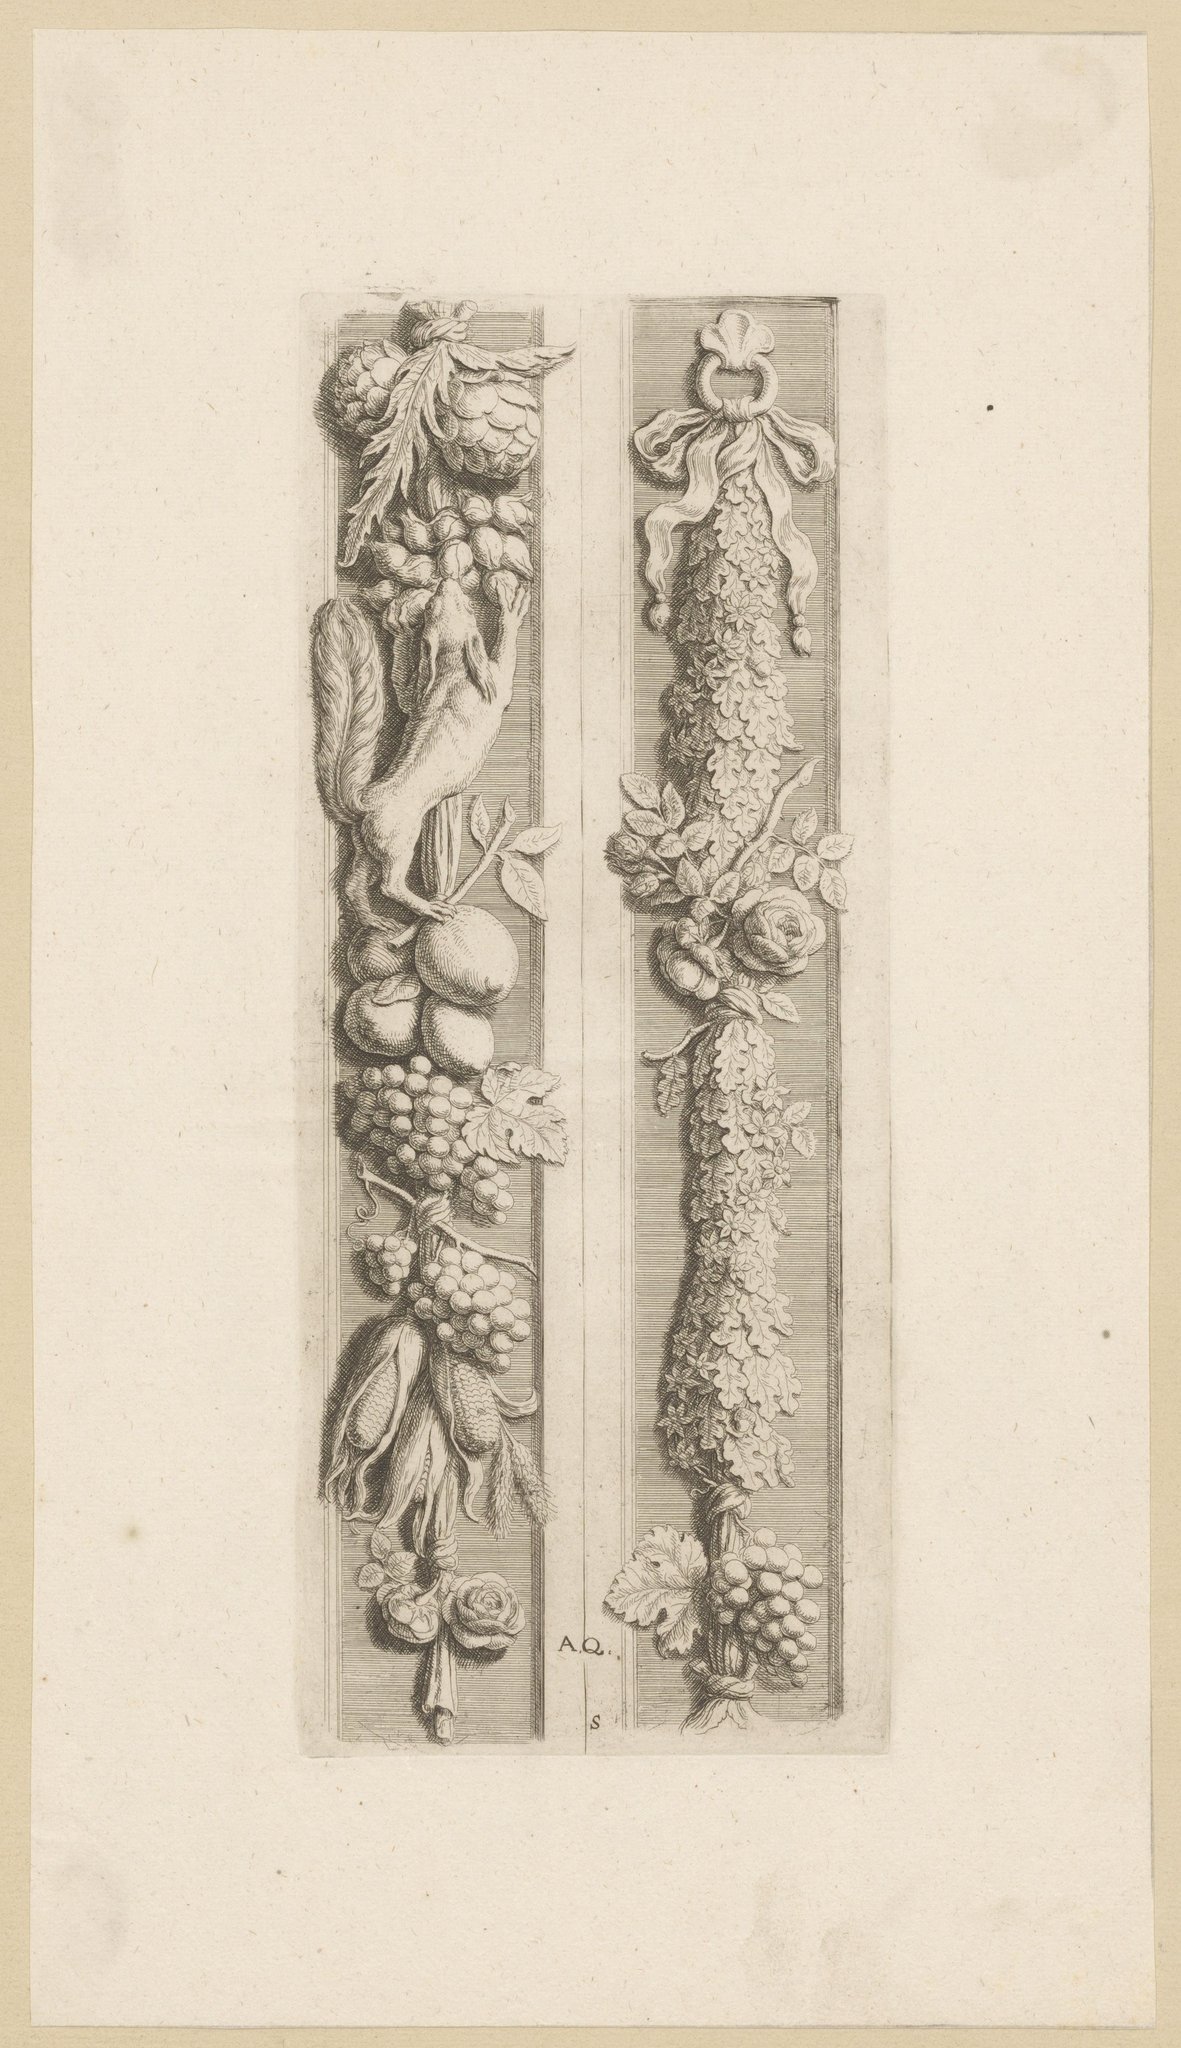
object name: print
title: Pilasterfestoen met eekhoorn, fruit, bloemen, bladeren en maïs tussen galerij en Burgerzaal in het Stadhuis op de Dam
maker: hubert quellinus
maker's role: print maker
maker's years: 1619-1687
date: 1655-1665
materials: paper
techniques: engraving, etching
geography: amsterdam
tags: fruits and vegetables ~ ornament, townhall, ornament ~ festoon, garland, rodents: squirrel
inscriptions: collector's mark: ‘16,59’ Lugt 1641b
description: Prent gebruikt in: Prima pars. Praecipuarum effigierum ac ornamentorum, amplissimae Curiae Amstelrodamensis (…) / Het eerste deel. Van de voornaemste Statuen ende Ciraten, vant konstijck Stadhuys van Amstelredam, tmeeste in marmer gemaeckt, door Artus Quellinus, Beelthouwer der voorseyde Stadt / La Premier Partie. De plusieurs Figures et ornements, de la Maison de Ville d'Amsterdam (…). Amsterdam: Artus Quellinus (I), 1655. Zie RP-P-AO-22-1-1 voor bijhorende titelpagina. Zie RP-P-AO-22-1-2 voor bijhorend register. Zie RP-P-AO-22-1A, RP-P-AO-22-1B, RP-P-AO-22-1C, RP-P-AO-22-1D-1, RP-P-AO-22-1D-2, RP-P-AO-22-1E, RP-P-AO-22-1F, RP-P-AO-22-1G, RP-P-AO-22-1H, RP-P-AO-22-1I, RP-P-AO-22-1K-1, RP-P-AO-22-1K-2, RP-P-AO-22-1K-3, RP-P-AO-22-1K-4, RP-P-AO-22-1K-5, RP-P-AO-22-1L-1, RP-P-AO-22-1L-2, RP-P-AO-22-1M-1, RP-P-AO-22-1M-2, RP-P-AO-22-1N-1, RP-P-AO-22-1N-2, RP-P-AO-22-1N-3, RP-P-AO-22-1N-4, RP-P-AO-22-1N-5, RP-P-AO-22-1O-1, RP-P-AO-22-1O-2, RP-P-AO-22-1O-3, RP-P-AO-22-1O-4, RP-P-AO-22-1P-1, RP-P-AO-22-1P-2, RP-P-AO-22-1P-3, RP-P-AO-22-1P-4, RP-P-AO-22-1Q-1, RP-P-AO-22-1Q-2, RP-P-AO-22-1Q-3, RP-P-AO-22-1Q-4, RP-P-AO-22-1R-1, RP-P-AO-22-1R-2, RP-P-AO-22-1R-3, RP-P-AO-22-1R-4, RP-P-AO-22-1R-5, RP-P-AO-22-1S-1, RP-P-AO-22-1S-2, RP-P-AO-22-1S-4, RP-P-AO-22-1S-5, RP-P-AO-22-1T-1 en RP-P-AO-22-1T-2 voor andere prenten uit deze publicatie. Zelfde staat van prent ook gebruikt in: Prima pars. Praecipuarum effigierum ac ornamentorum, amplissimae Curiae Amstelrodamensis (…) / Het eerste deel. Van de voornaemste Statuen ende Ciraten, vant konstijck Stadhuys van Amstelredam, tmeeste in marmer gemaeckt, door Artus Quellinus, Beelthouwer der voorseyde Stadt / La Premier Partie. De plusieurs Figures et ornements, de la Maison de Ville d'Amsterdam (…). Amsterdam: Frederik de Wit, 1665. Latere staat van prent ook gebruikt in: Architecture peinture et sculpture de la Maison de Ville d'Amsterdam, representee en CIX. figures en taille-douce (…). Amsterdam: David Mortier, 1719. En in: Architecture peinture et sculpture de la Maison de Ville d'Amsterdam, representee en CIX. figures en taille-douce (…). Amsterdam: Gerard Valck, 1719. En in: Bouw schilder en beeldhouwkonst, van het Stadhuis te Amsteldam, vertoont in CIX figuuren (…). Amsterdam: Covens & Mortier & Covens Jr., s.a. (1774-1783).